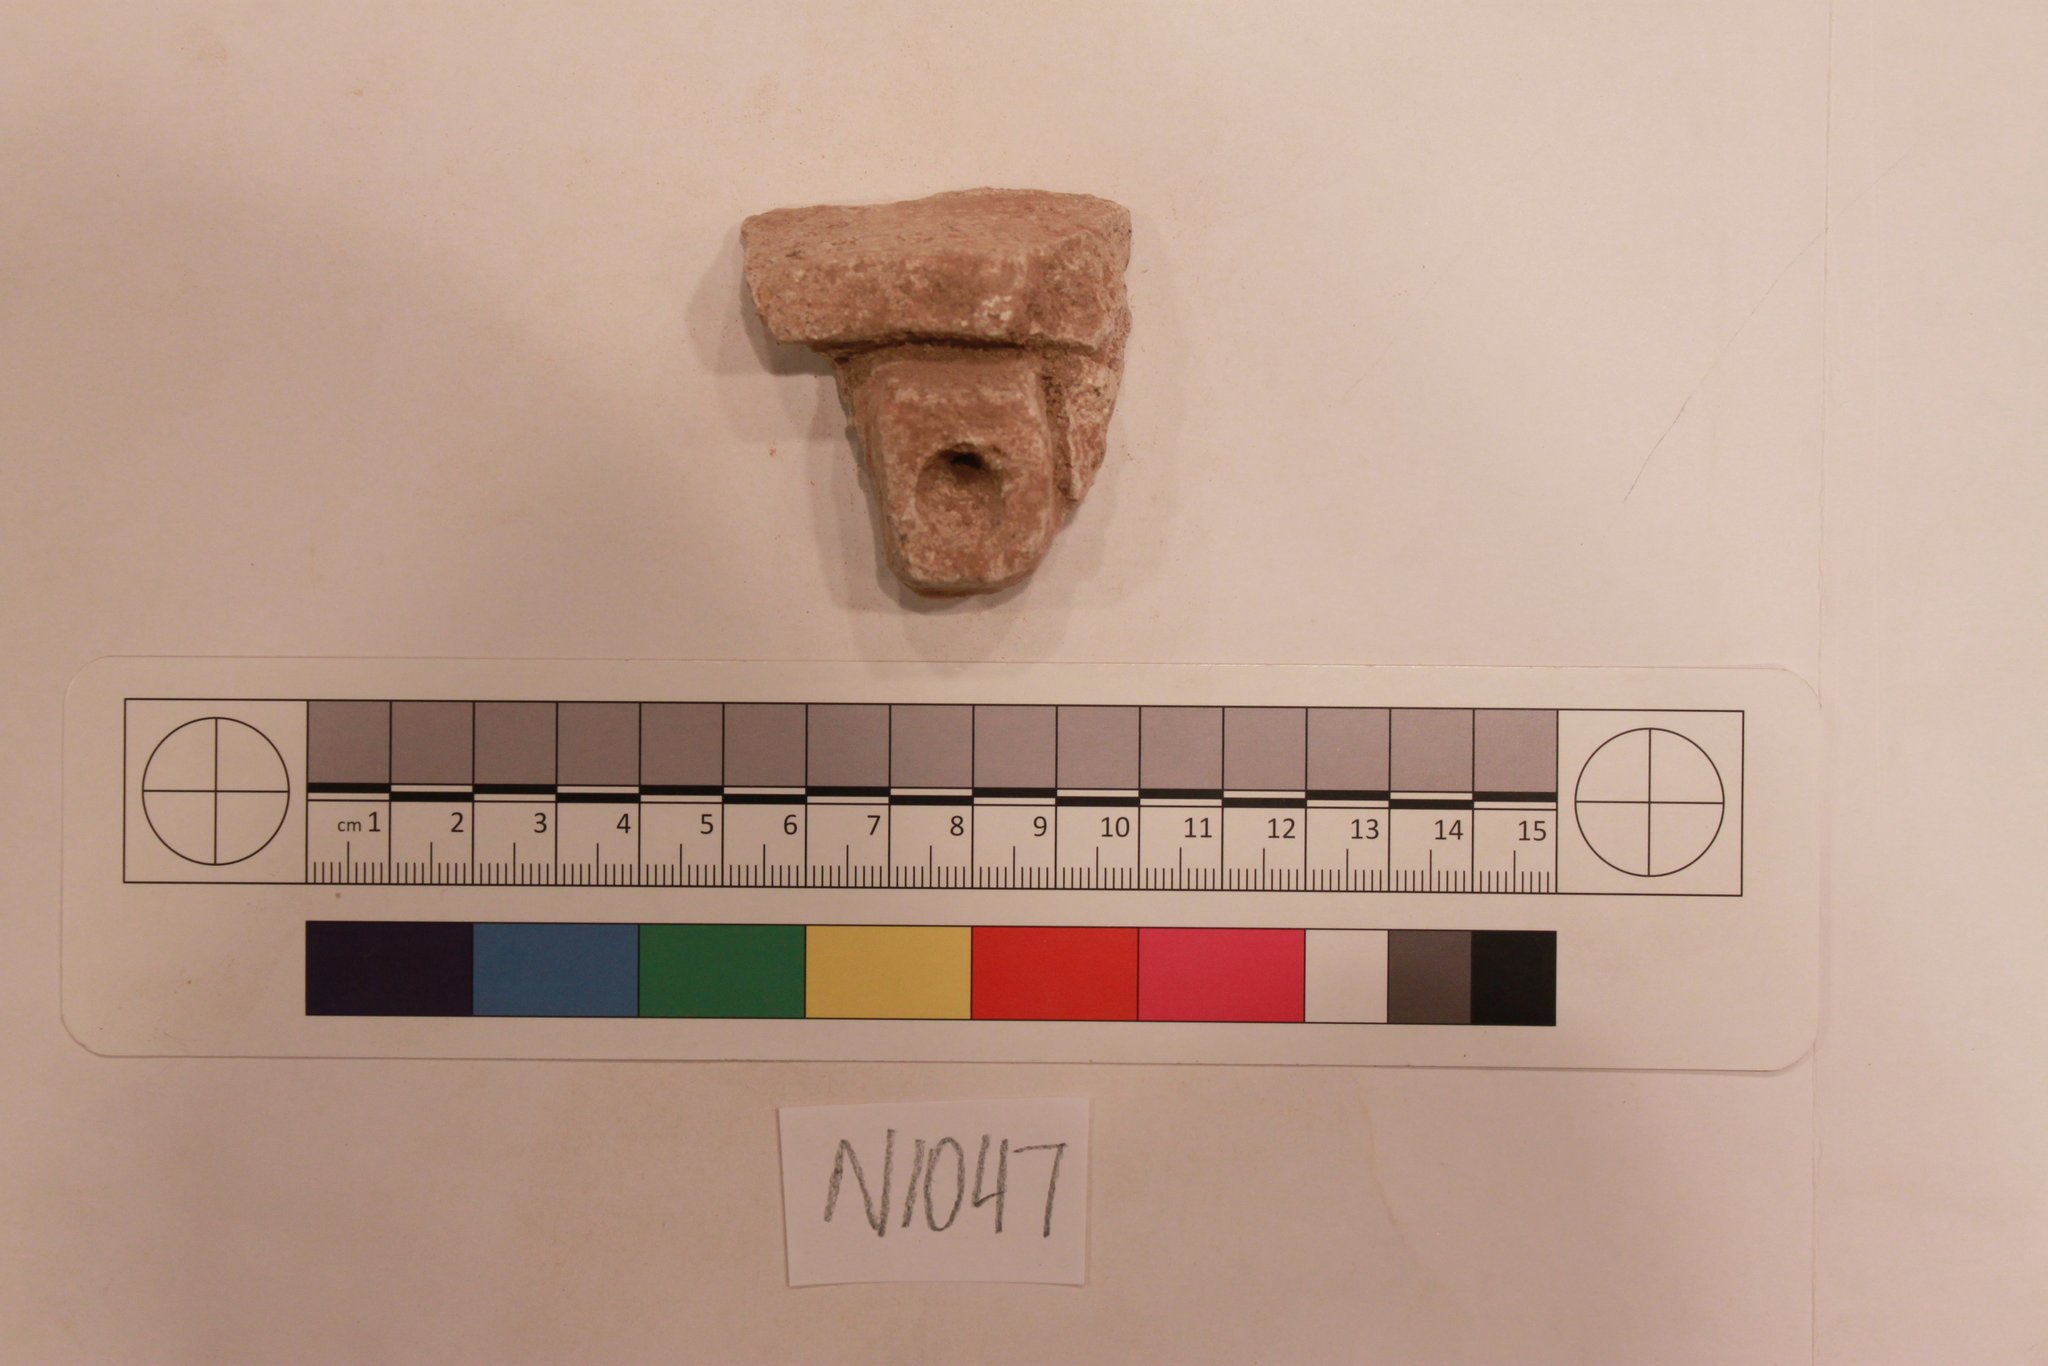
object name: fragment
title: Stucco Fragment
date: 701-1200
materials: plaster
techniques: carving, painting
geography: iran